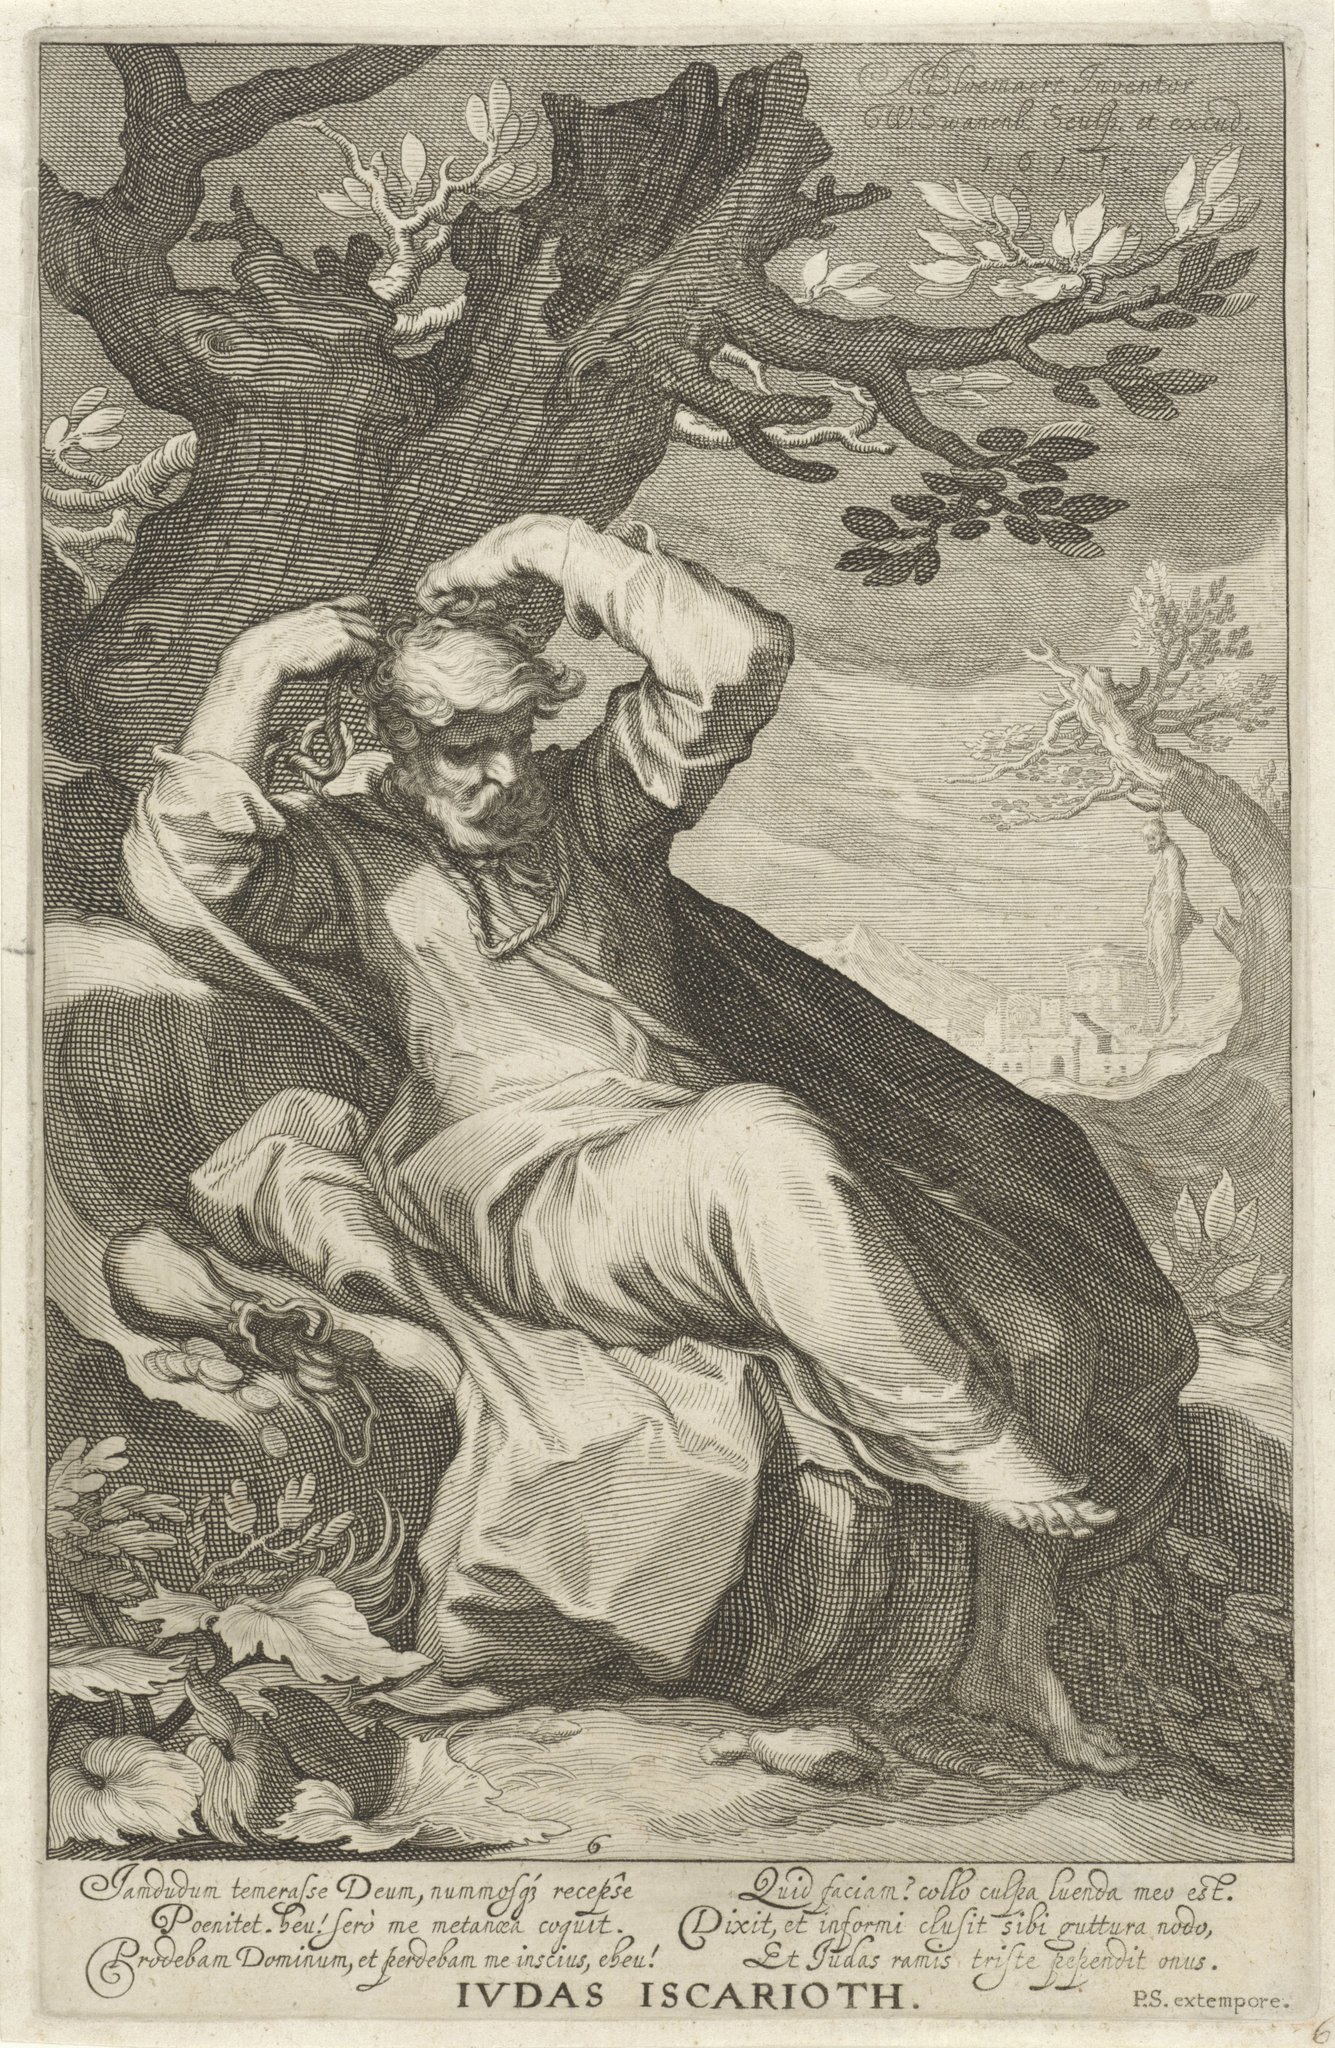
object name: print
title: Judas Iskariot hangt zich op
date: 1611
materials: paper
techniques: engraving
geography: utrecht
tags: judas hanging himself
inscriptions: collector's mark: Lugt 11, collector's mark: Lugt 10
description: Judas Iskariot zit onder een boom en knoopt een touw om zijn nek. Naast hem ligt een geldbuidel. Rechts in de verte hangt hij aan een boom. Onder de voorstelling bevindt zich een zesregelige, Latijnse tekst met een beschrijving van de scène.